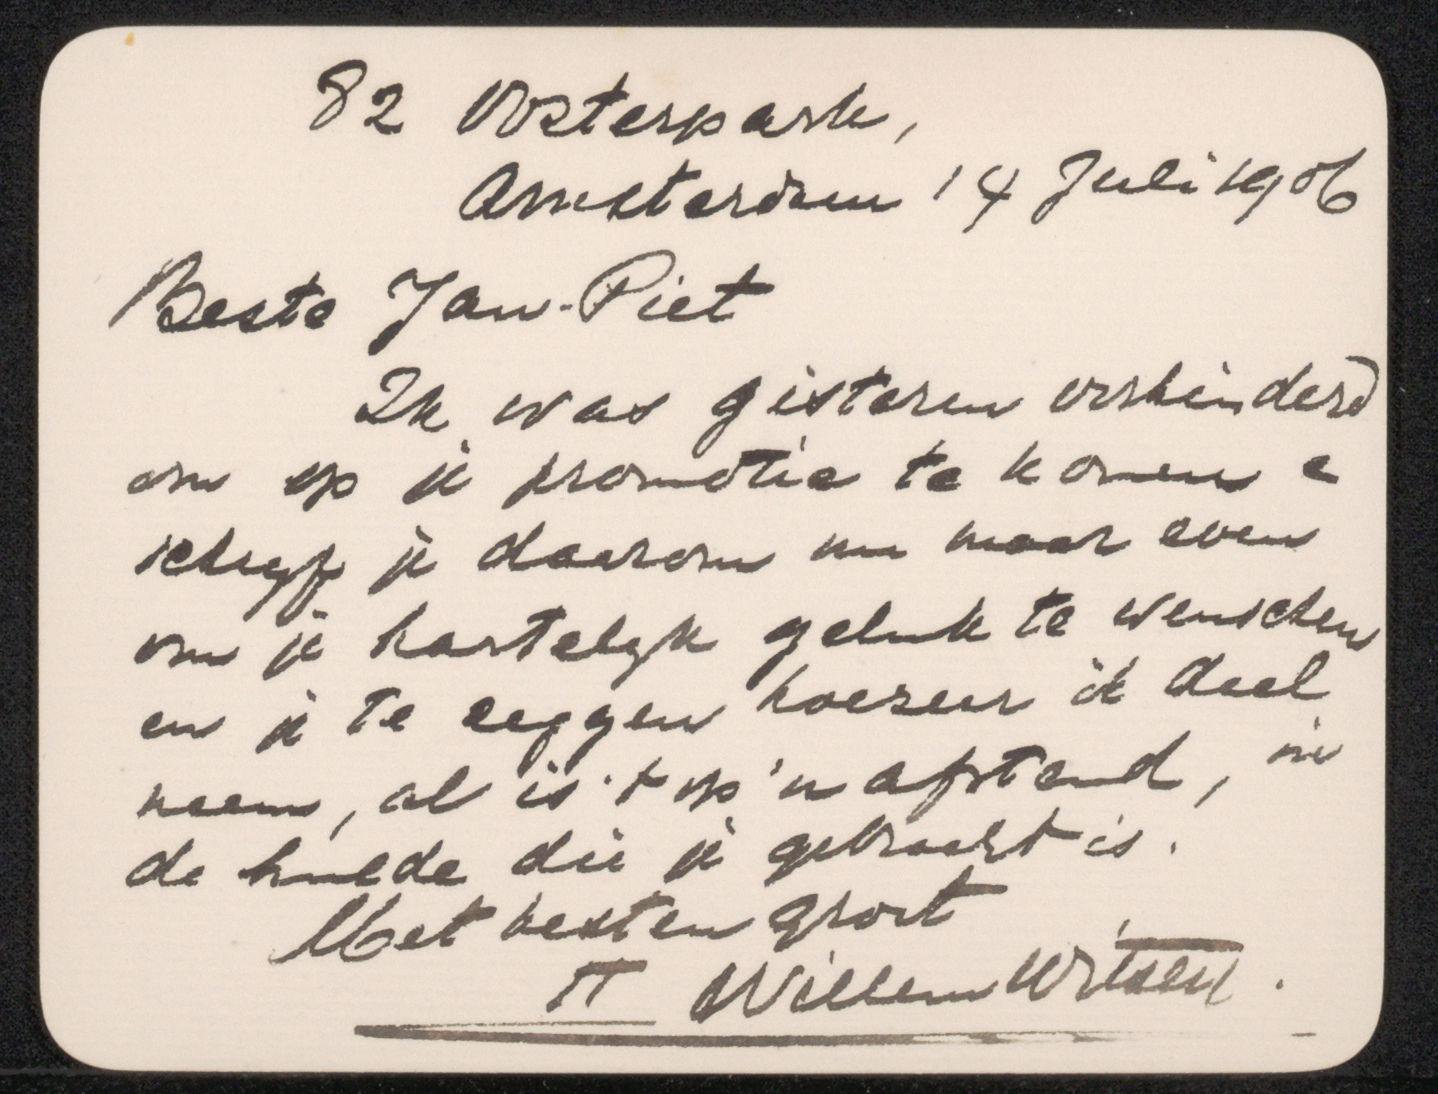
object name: letter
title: Brief aan Jan Veth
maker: willem witsen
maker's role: draughtsman, painter, print maker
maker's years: 1860-1923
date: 1906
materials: cardboard, ink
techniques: pen, writing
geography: amsterdam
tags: dordrecht, painter, print maker, draughtsman, designer, jan veth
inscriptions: collector's mark: ‘RPK’